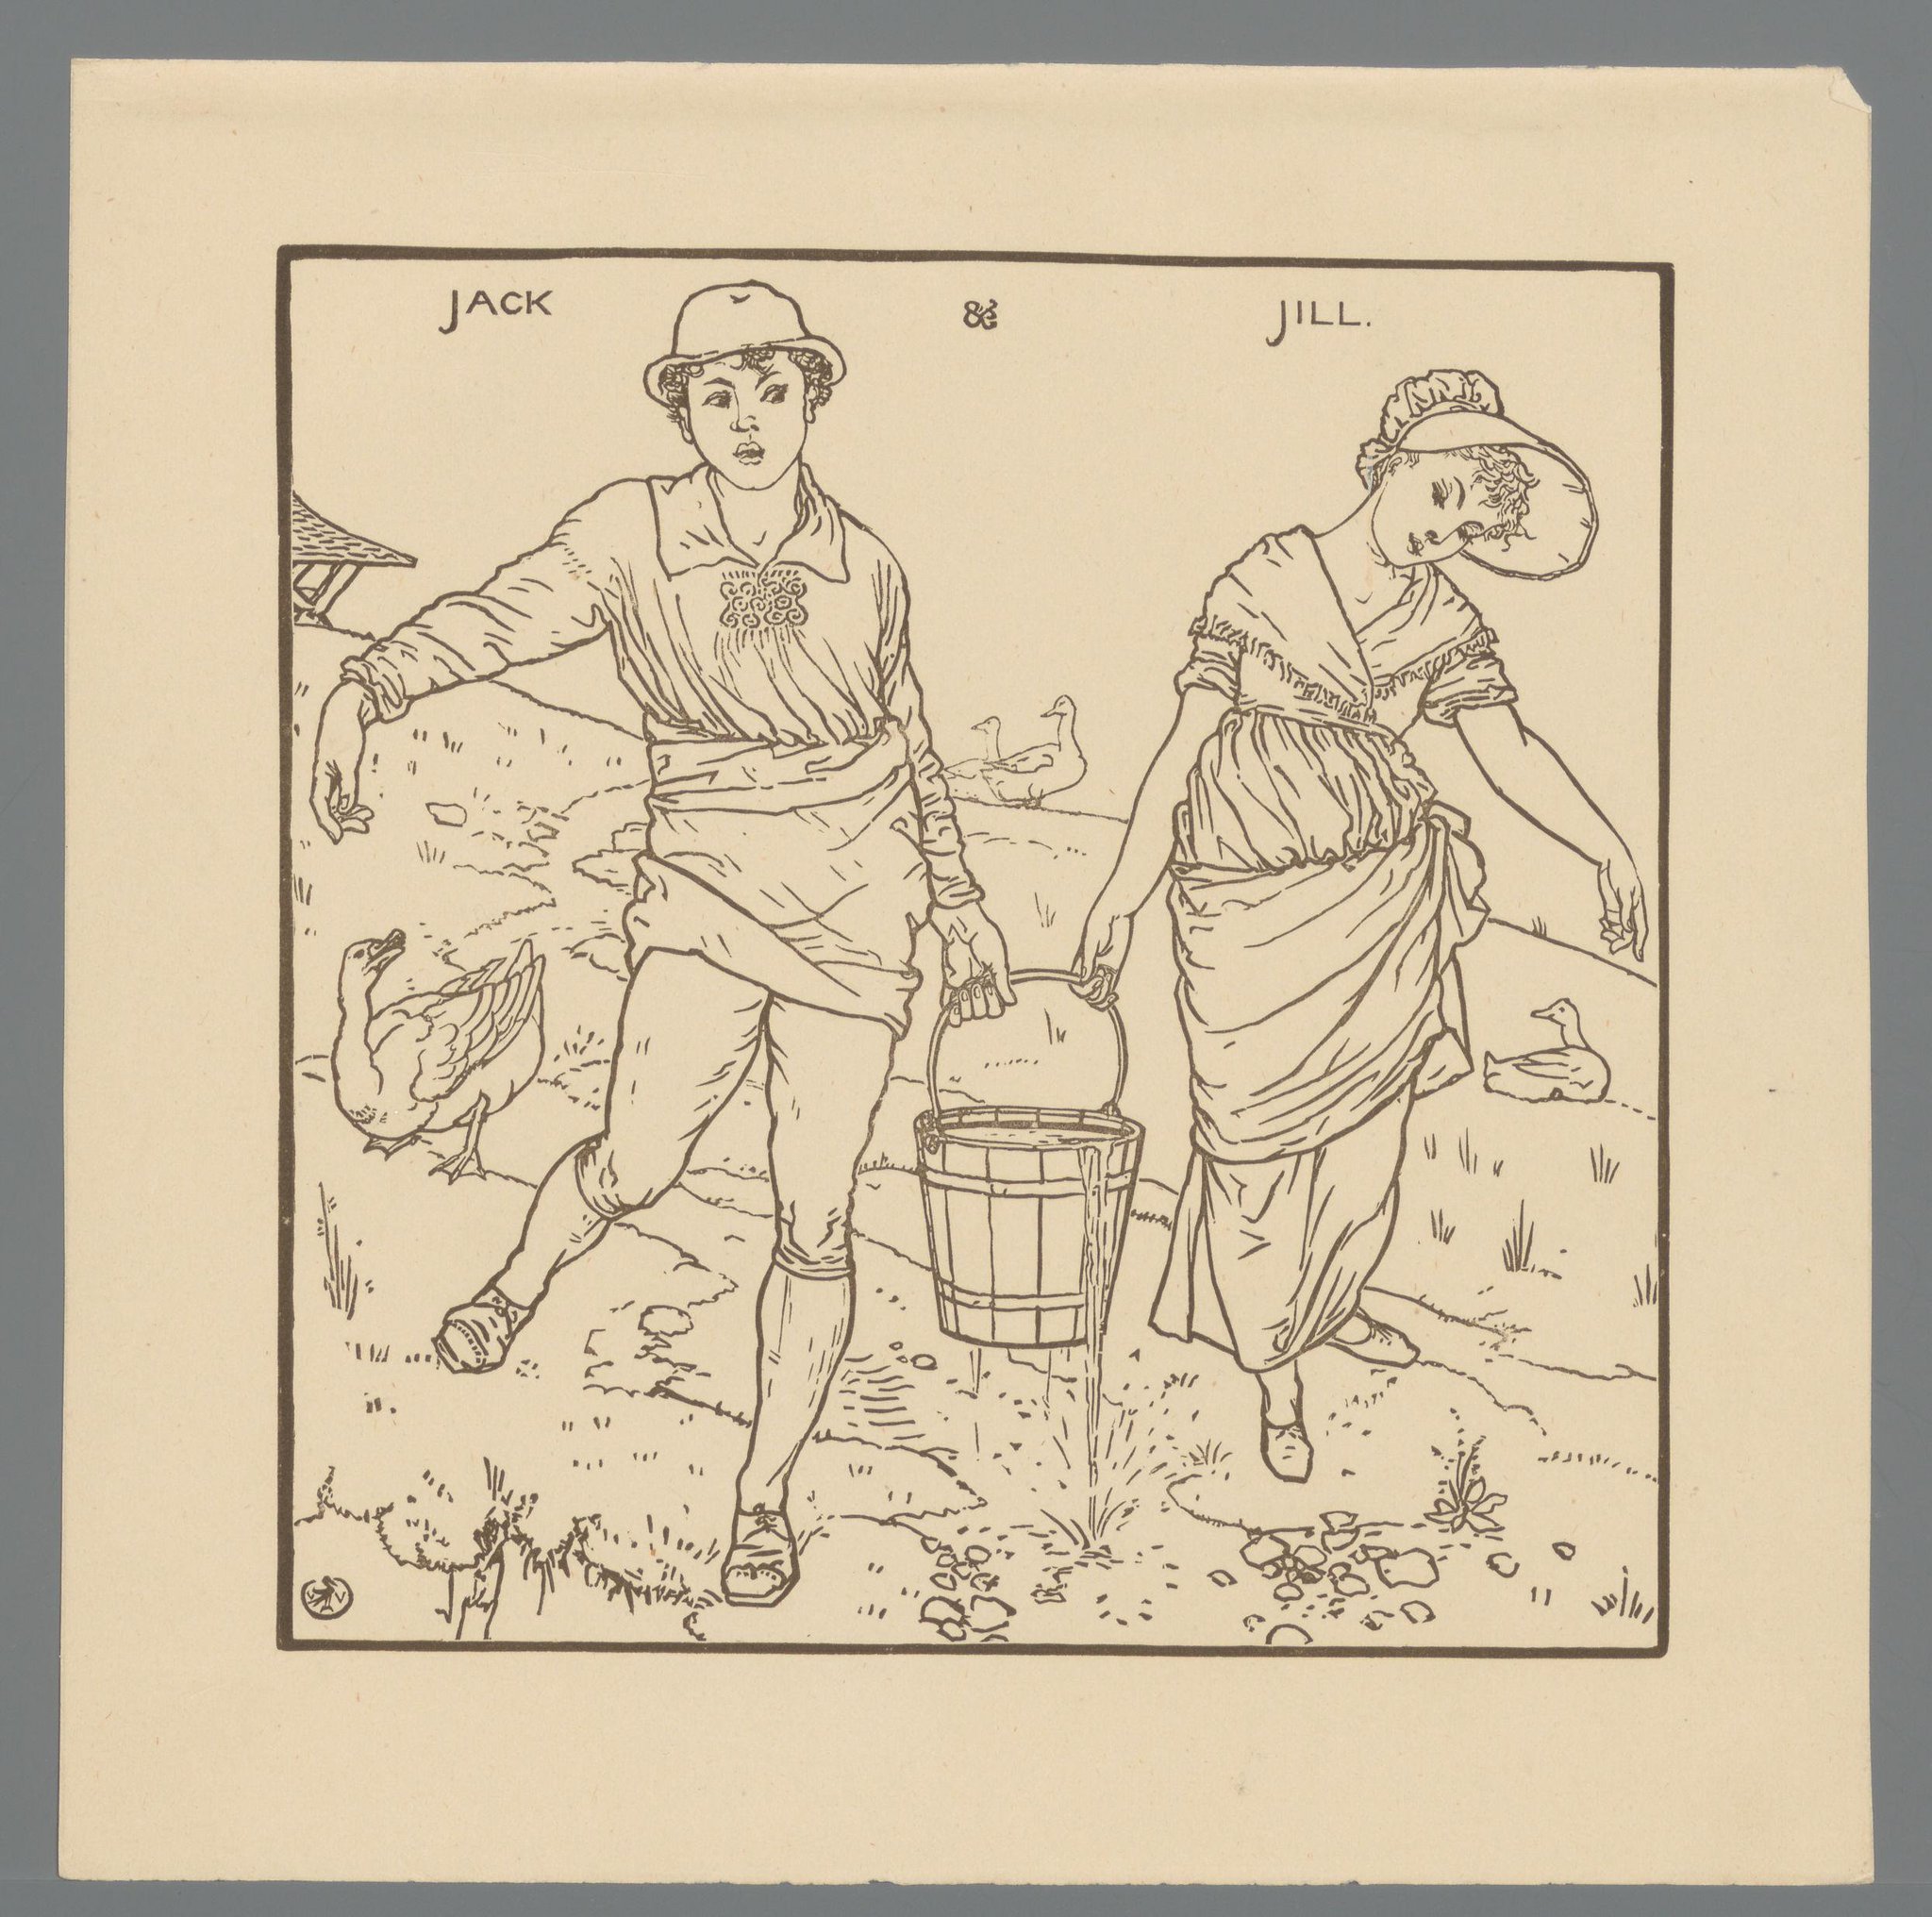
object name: print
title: Jongen en meisje dragen een emmer water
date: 1887-1927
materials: paper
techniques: engraving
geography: london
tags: adolescent, young woman, maiden, wooden container: barrel, cask, bucket, carrying something, youth, adolescent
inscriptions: collector's mark: Lugt 2228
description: Prent uit: Walter Crane's painting book. Londen: Routledge & Sons, 1887. Of een latere uitgave. Dit boek bevat twaalf voorstellingen die in kleur en lijntekening zijn gedrukt om te gebruiken als (in)kleurboek. De voorstellingen zijn afkomstig uit eerdere werken van Crane.